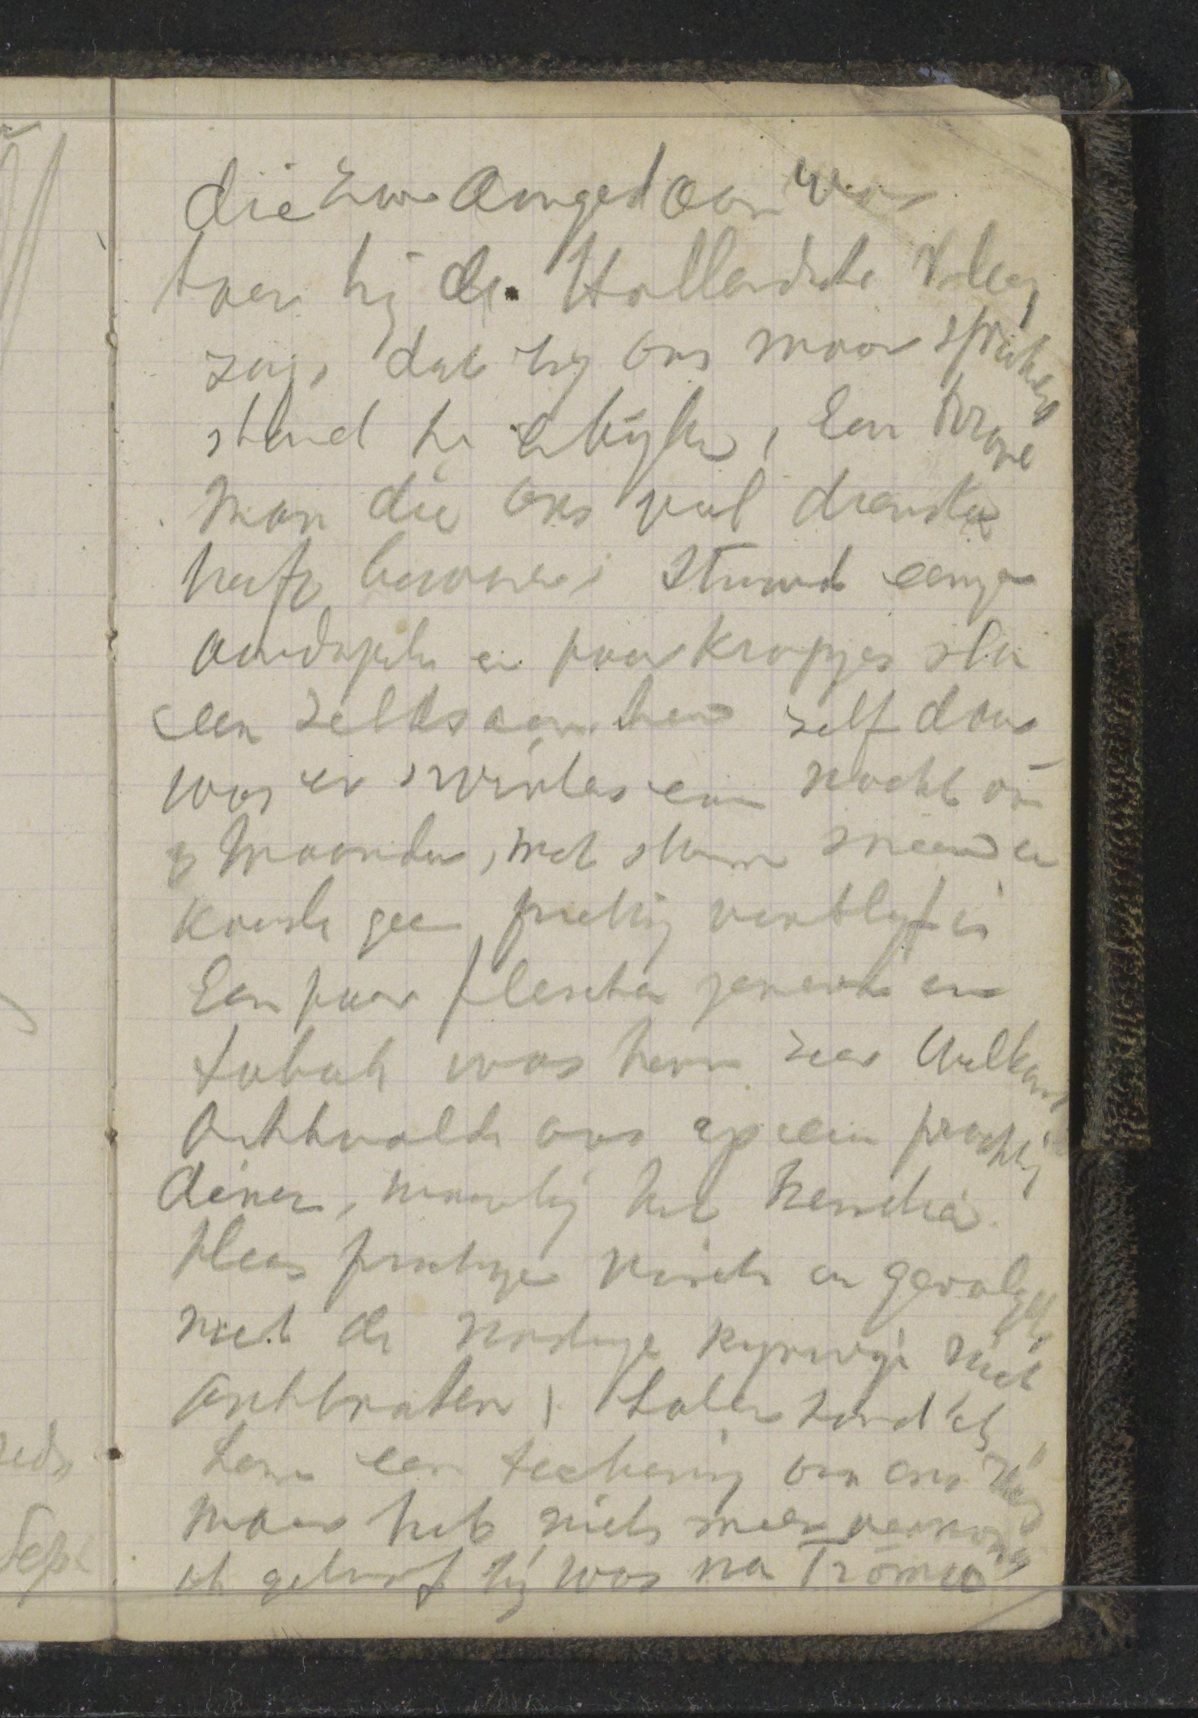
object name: sketchbook leaf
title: Reisverslag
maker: louis apol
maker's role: draughtsman, painter, print maker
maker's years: 1850-1936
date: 1809-1880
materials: pencil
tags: nova zembla expedities 1880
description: Blad 107 recto uit een schetsboek met 110 bladen betekend tijdens de expeditie naar Nova Zembla in 1880.